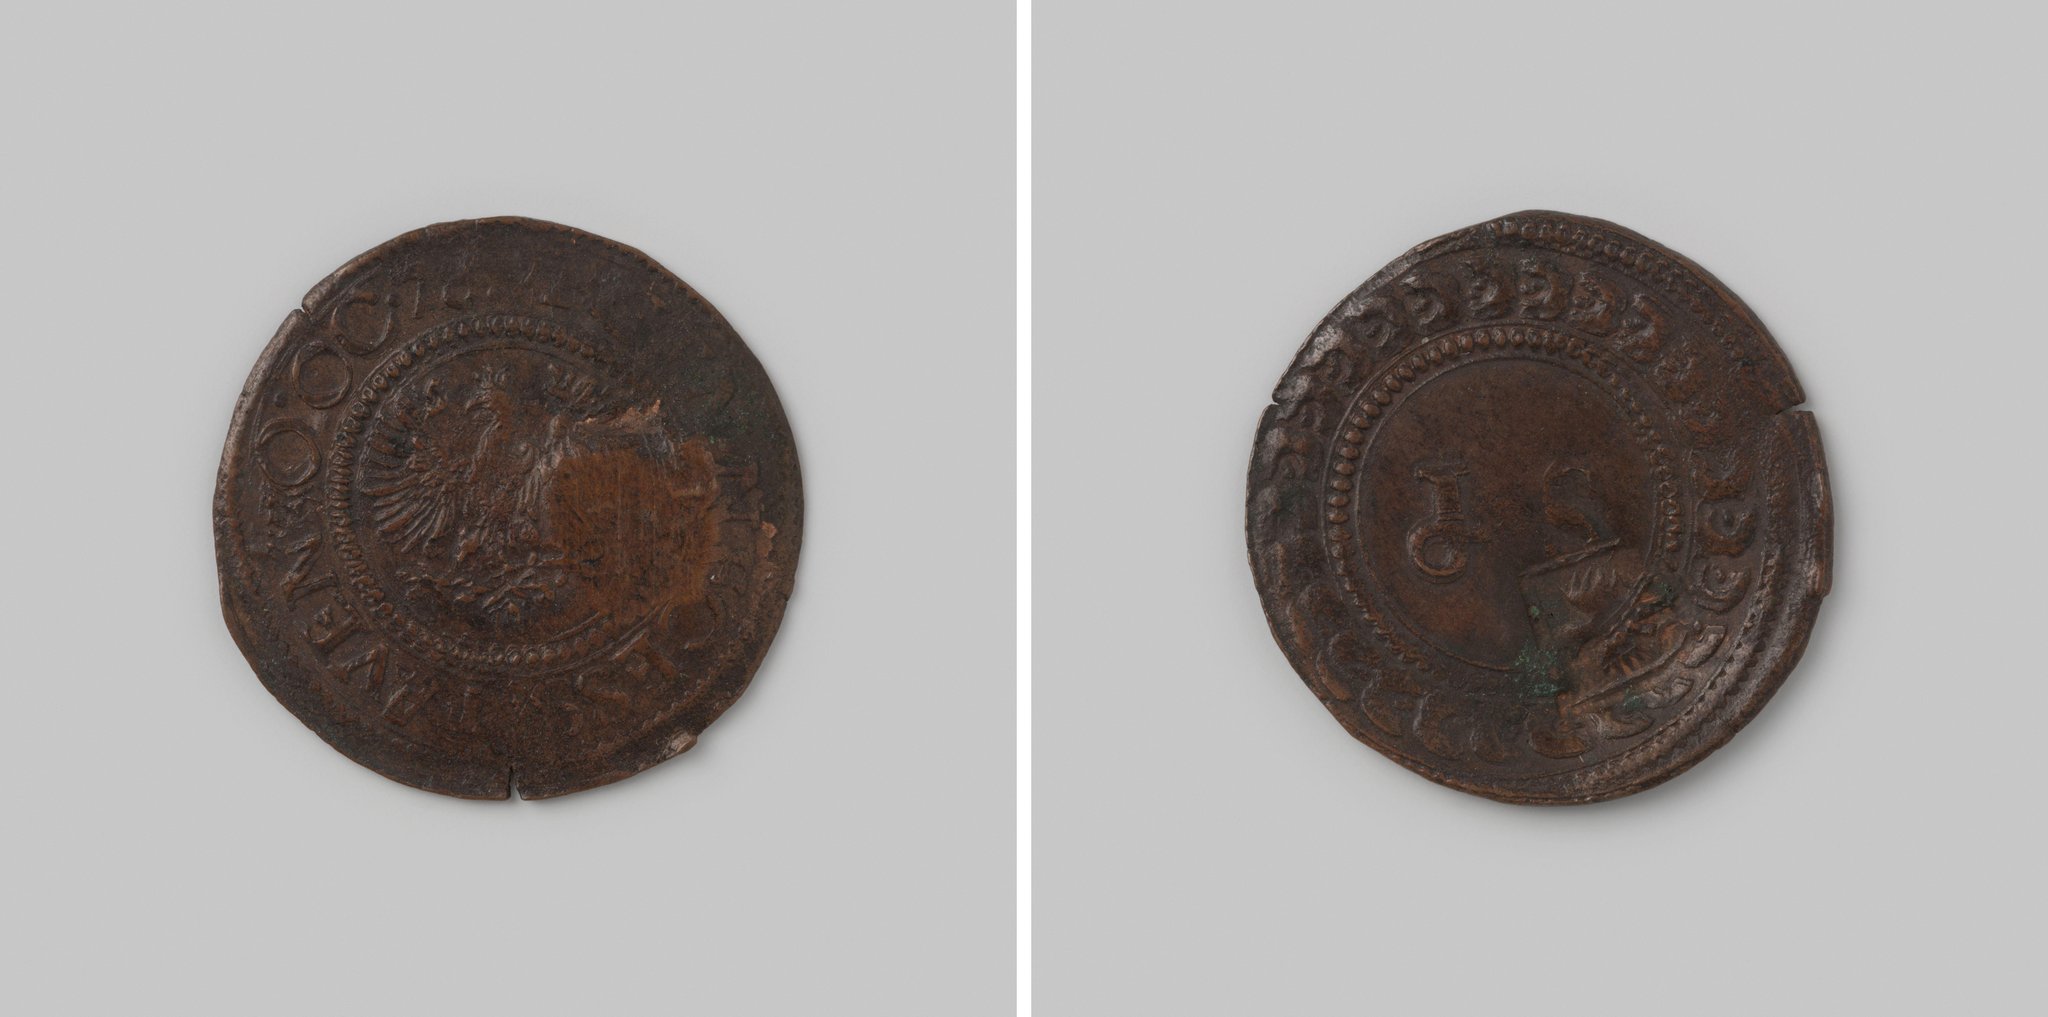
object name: siege coin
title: Halve stuiver, noodmunt uit Deventer, geslagen tijdens het beleg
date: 1578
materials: copper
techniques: striking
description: Koperen noodmunt. Voorzijde: binnen parelcirkel gekroonde enkelkoppige adelaar naar links. Omschrift: Vrgen. Necess [stadswapenschildje] Daven. 30 Oc 78. Keerzijde: binnen parelcirkel op een regel waarde-aanduiding: ½ S. Buiten parelcirkel krans. Met klop stadswapenschildje?.